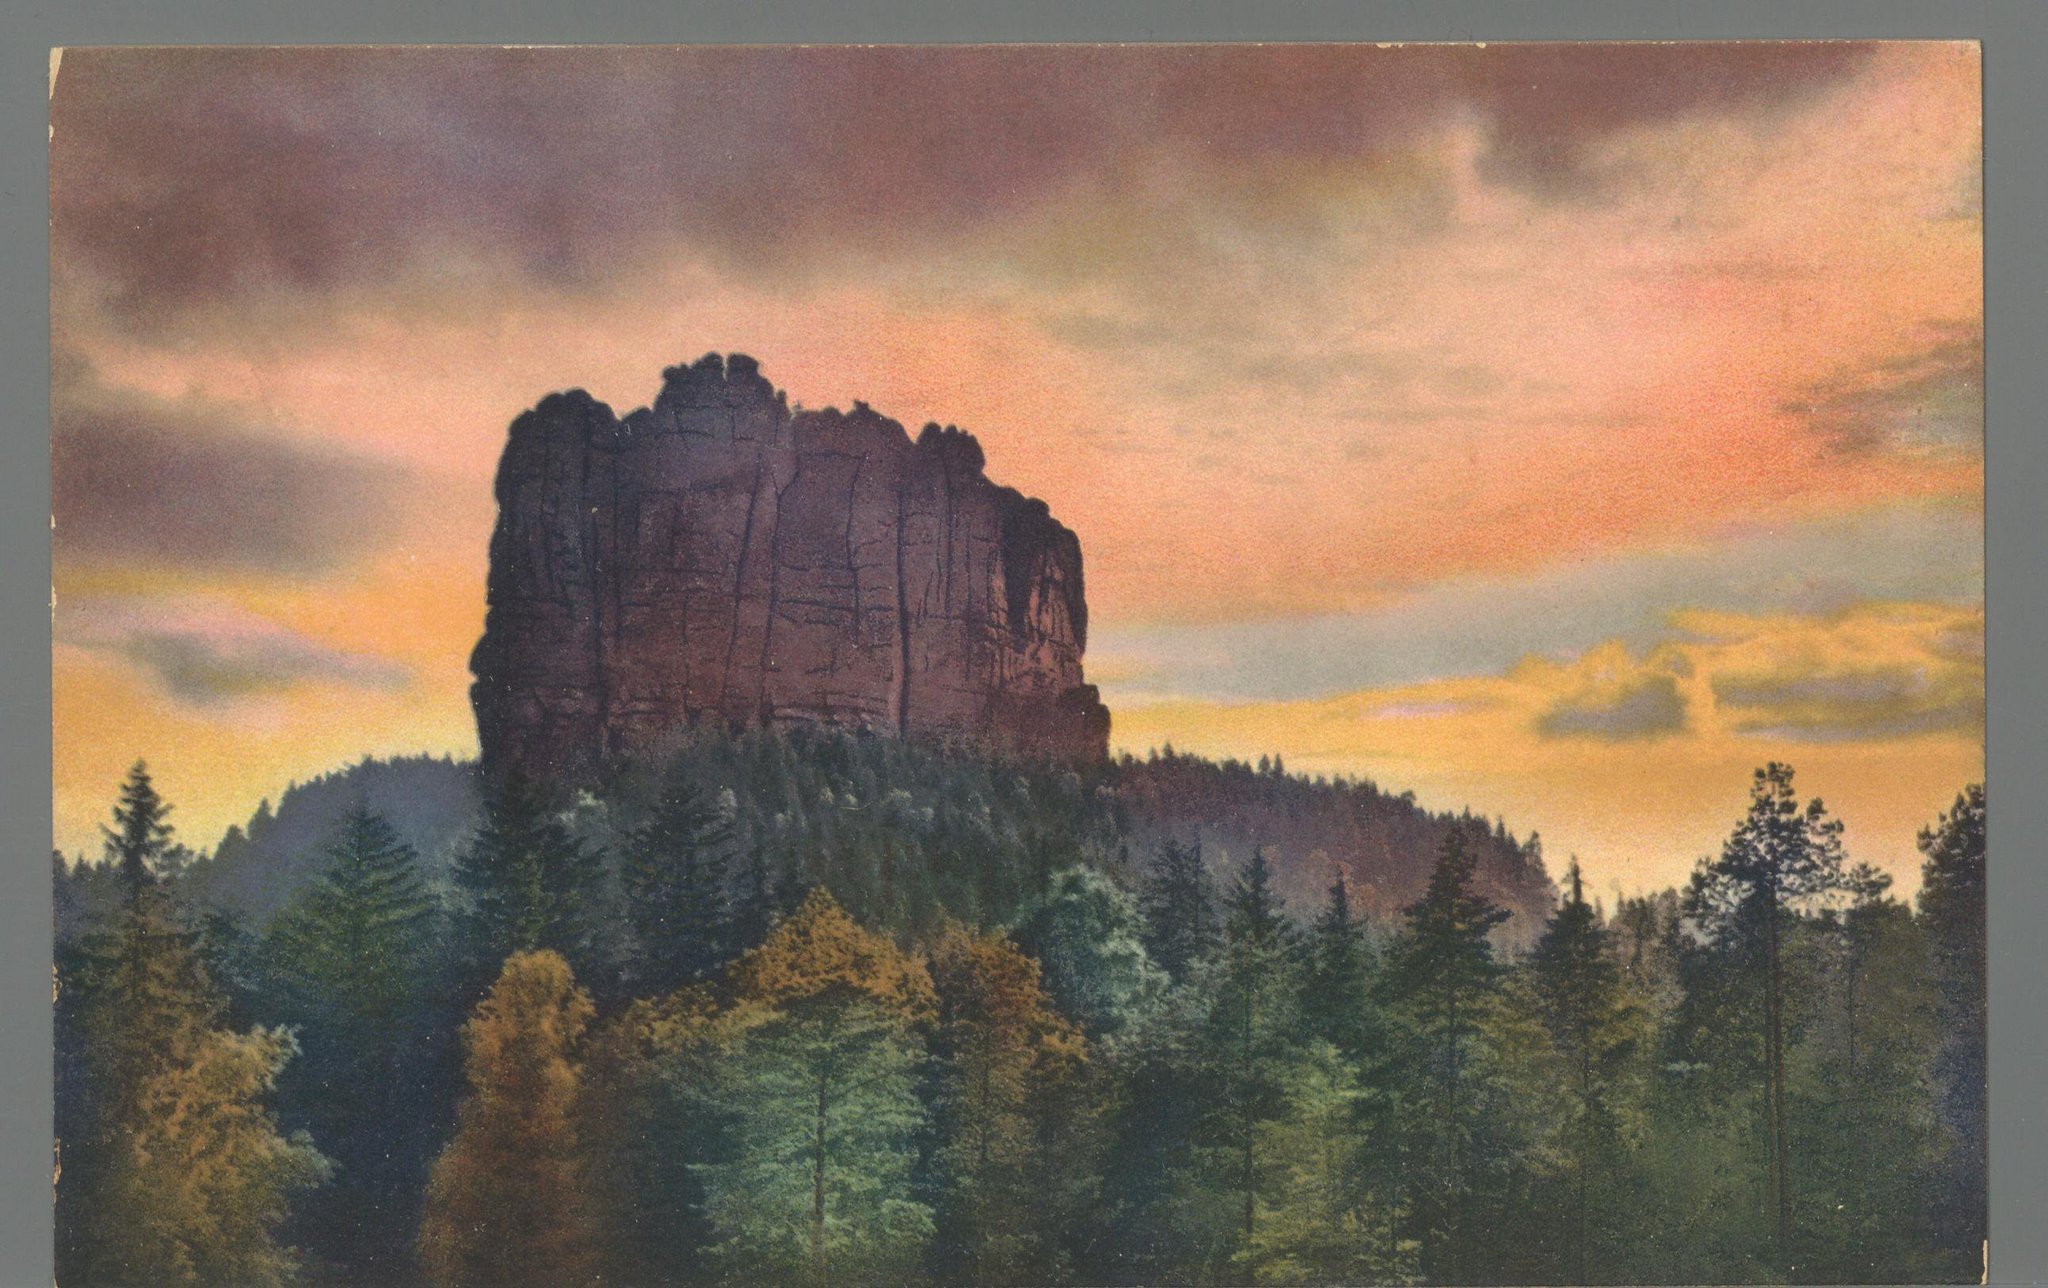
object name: ansichtkaart, prentbriefkaart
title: Gezicht op een rotsformatie in de Sächsische Schweiz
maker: Anonymous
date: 1905-1930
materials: cardboard, photographic process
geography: dresden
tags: rock-formations